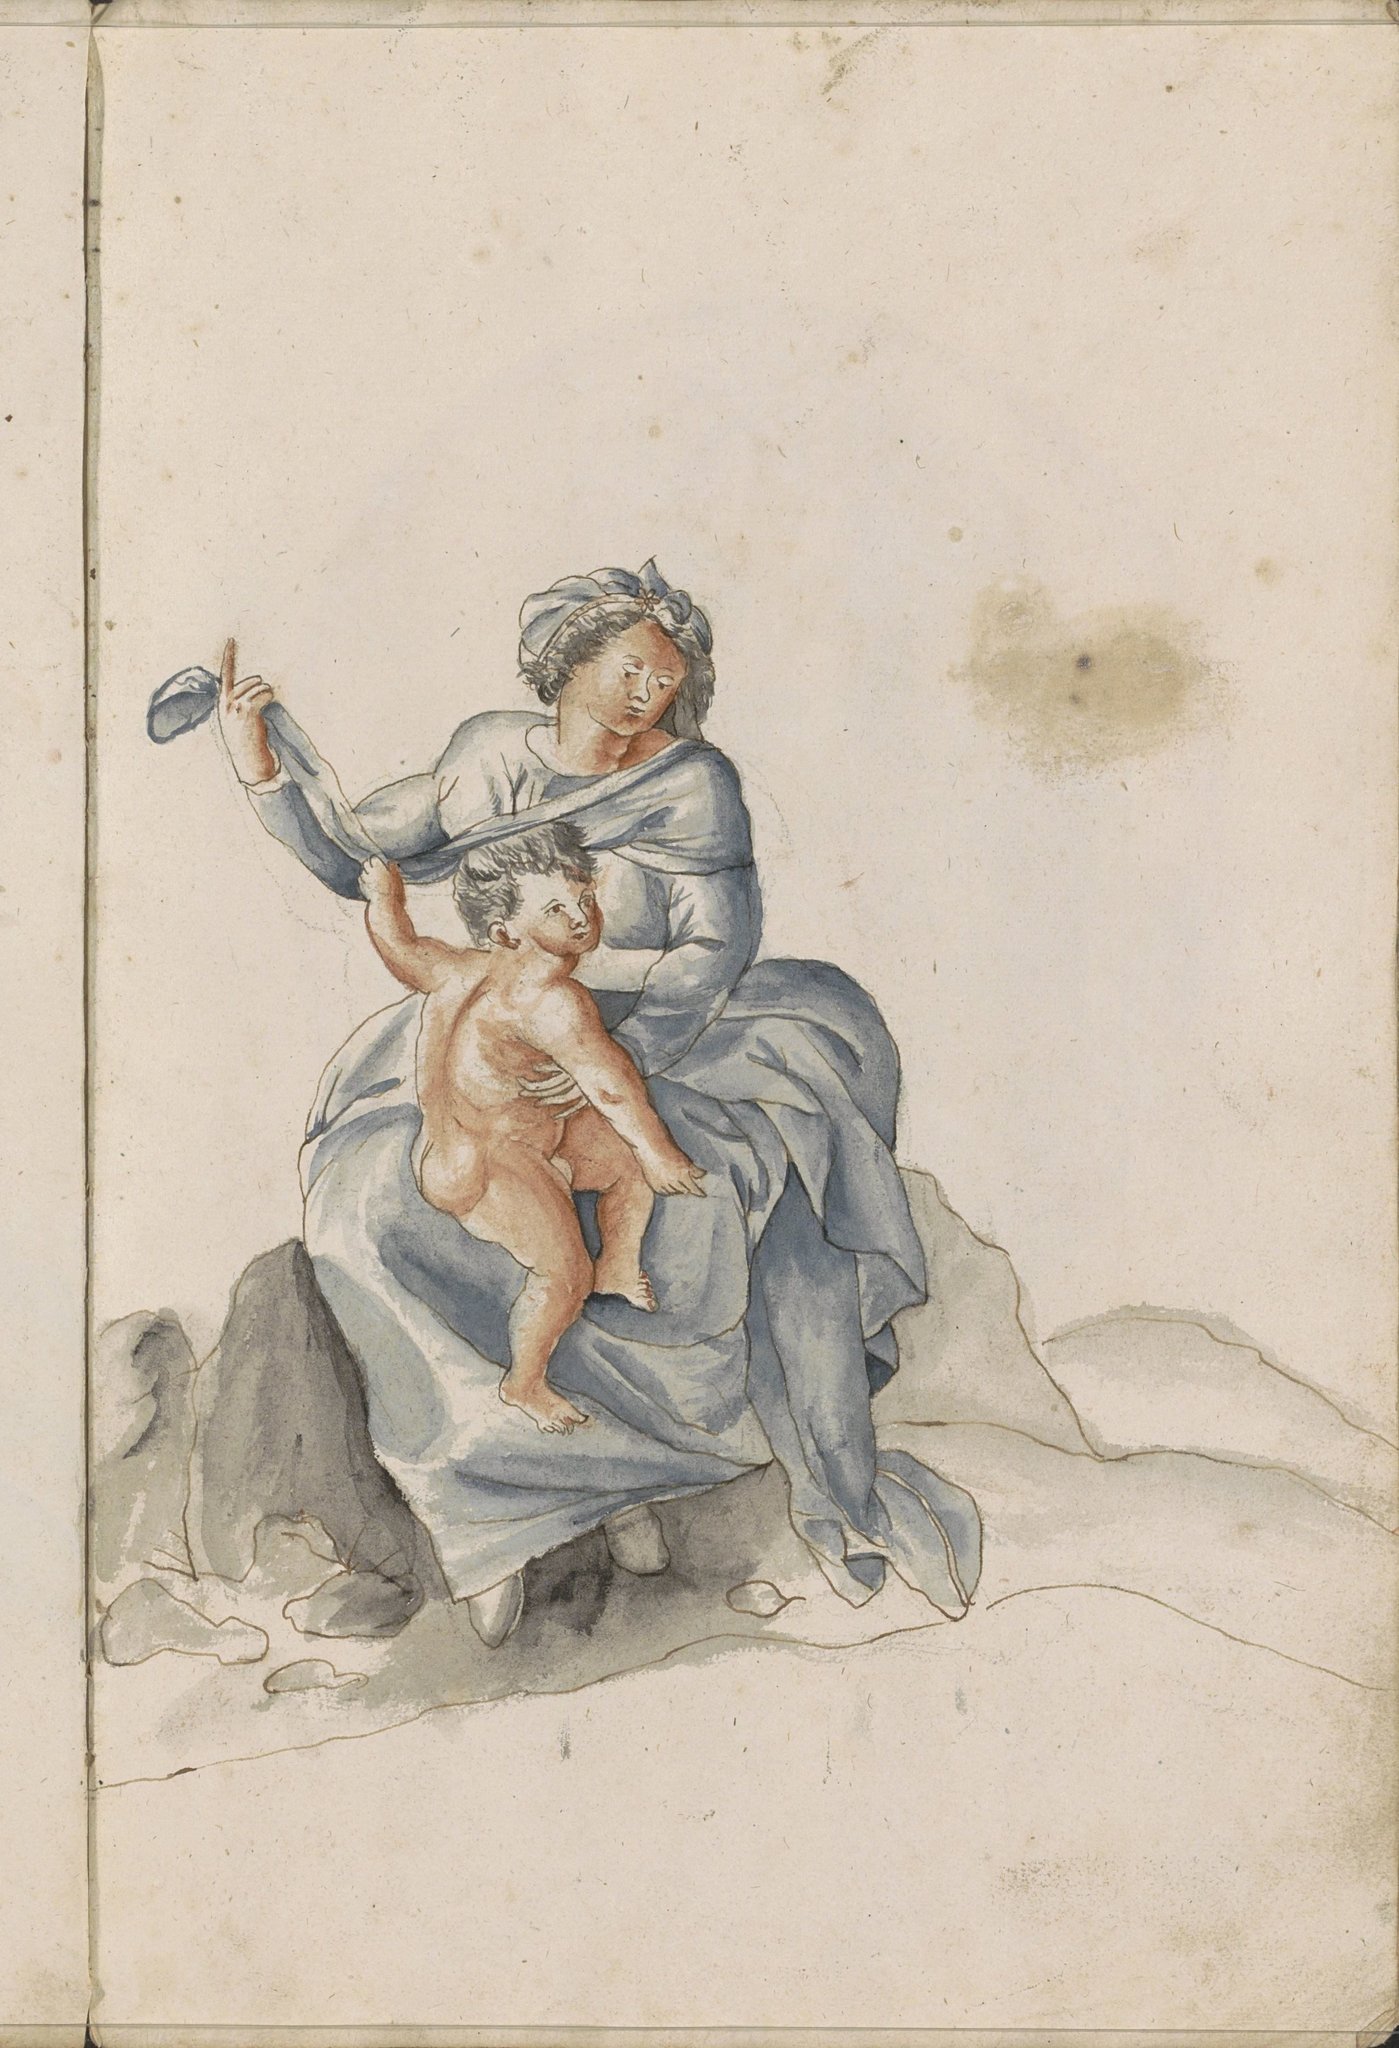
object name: sketchbook leaf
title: Madonna op een rots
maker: hendrick van beaumont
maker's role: draughtsman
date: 1696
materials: ink, paper, watercolor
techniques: brush, pen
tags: madonna: i.e. mary with the christ-child, rocks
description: Vermoedelijk een tekening naar een prent. Blad 83 recto uit een schetsboek met 91 bladen.